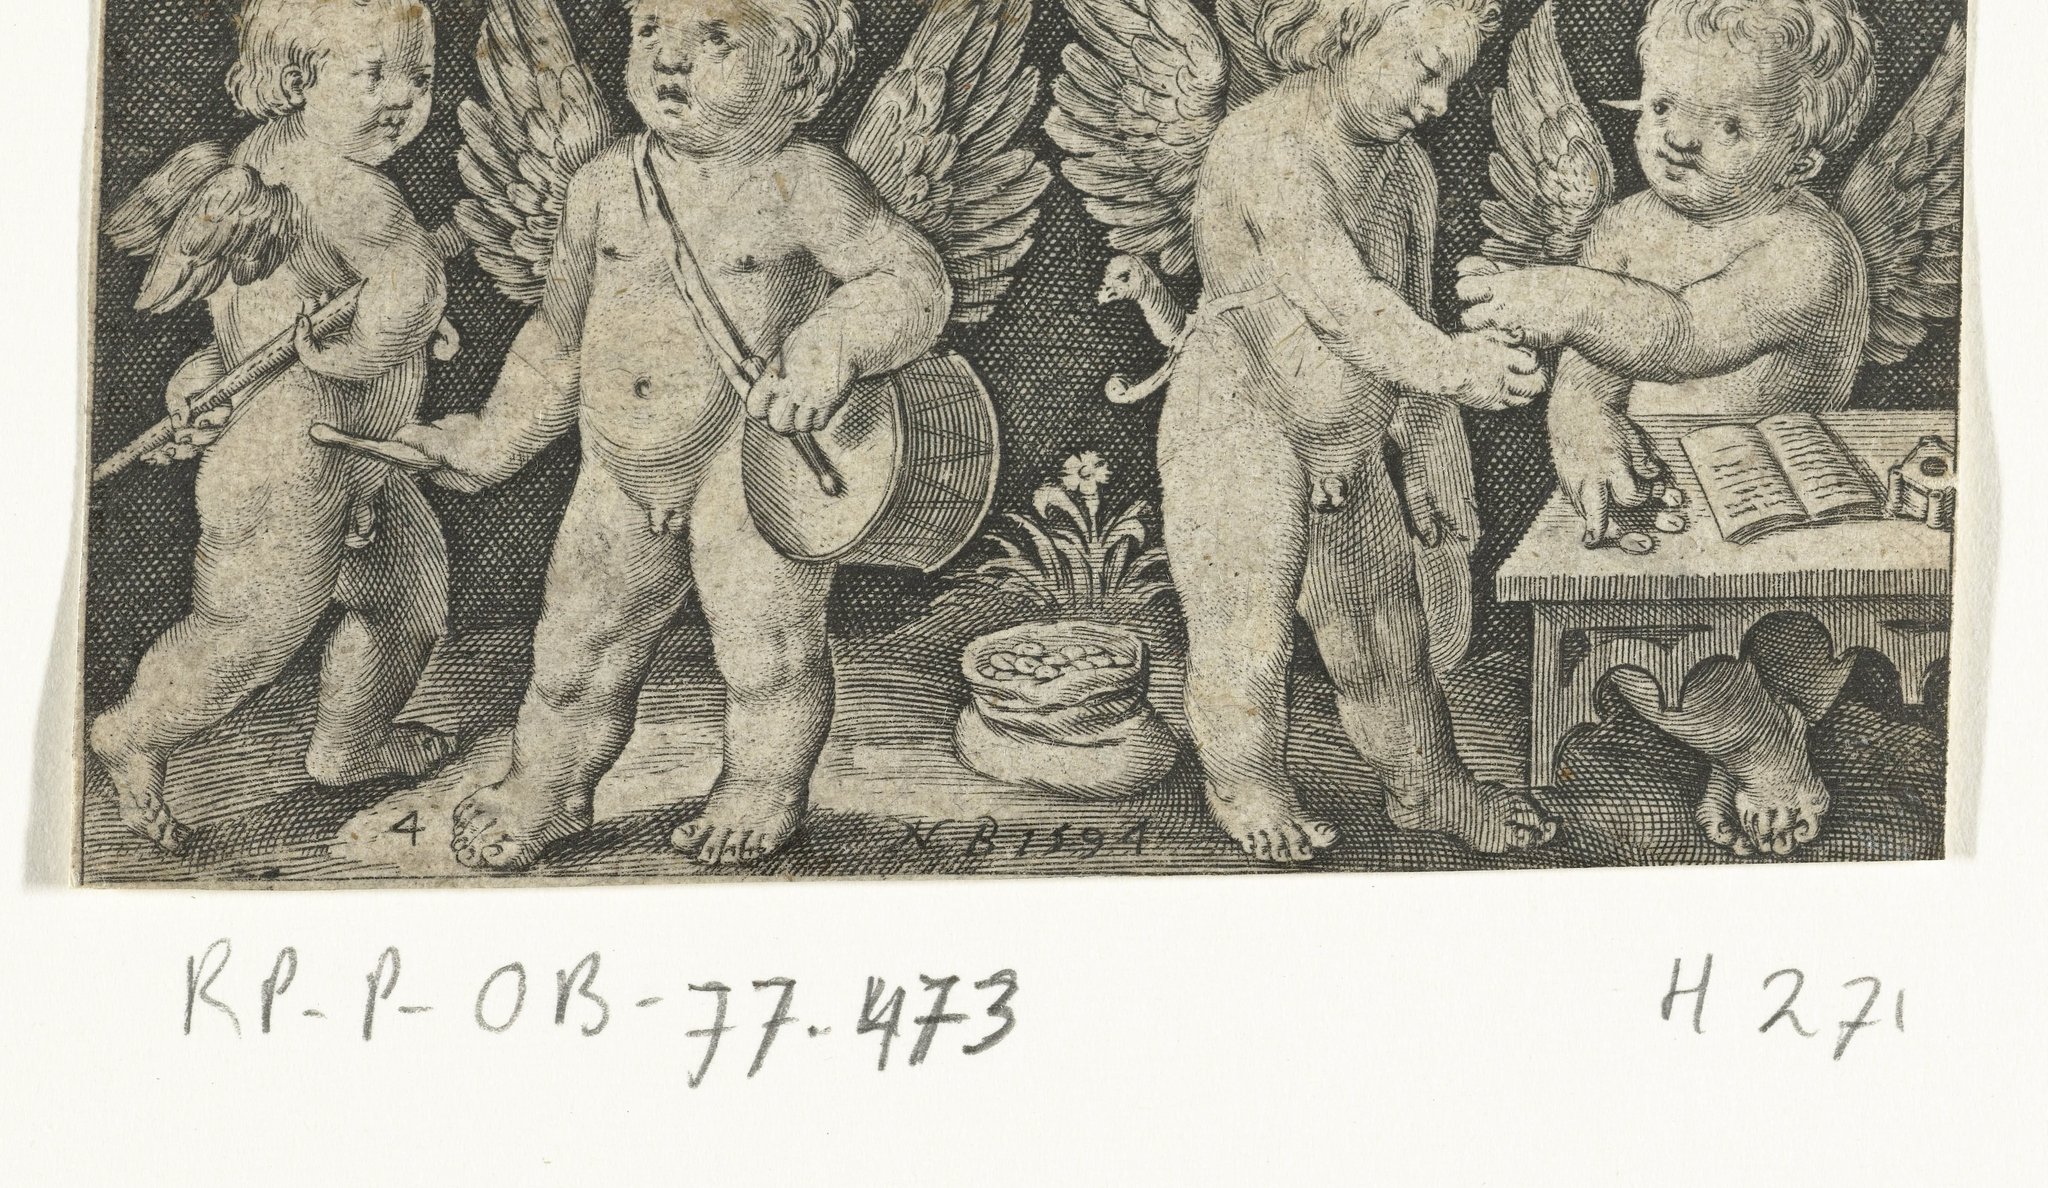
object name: print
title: Friezen met kinderen, engeltjes en dieren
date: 1594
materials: paper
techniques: engraving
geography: netherlands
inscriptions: collector's mark: Lugt 740, collector's mark: Lugt 2228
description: Prent uit serie van zes prenten met Friezen met kinderen, engeltjes en dieren. Hollstein beschrijft deze serie twee keer onder de nrs. 142-147 en 268-273.